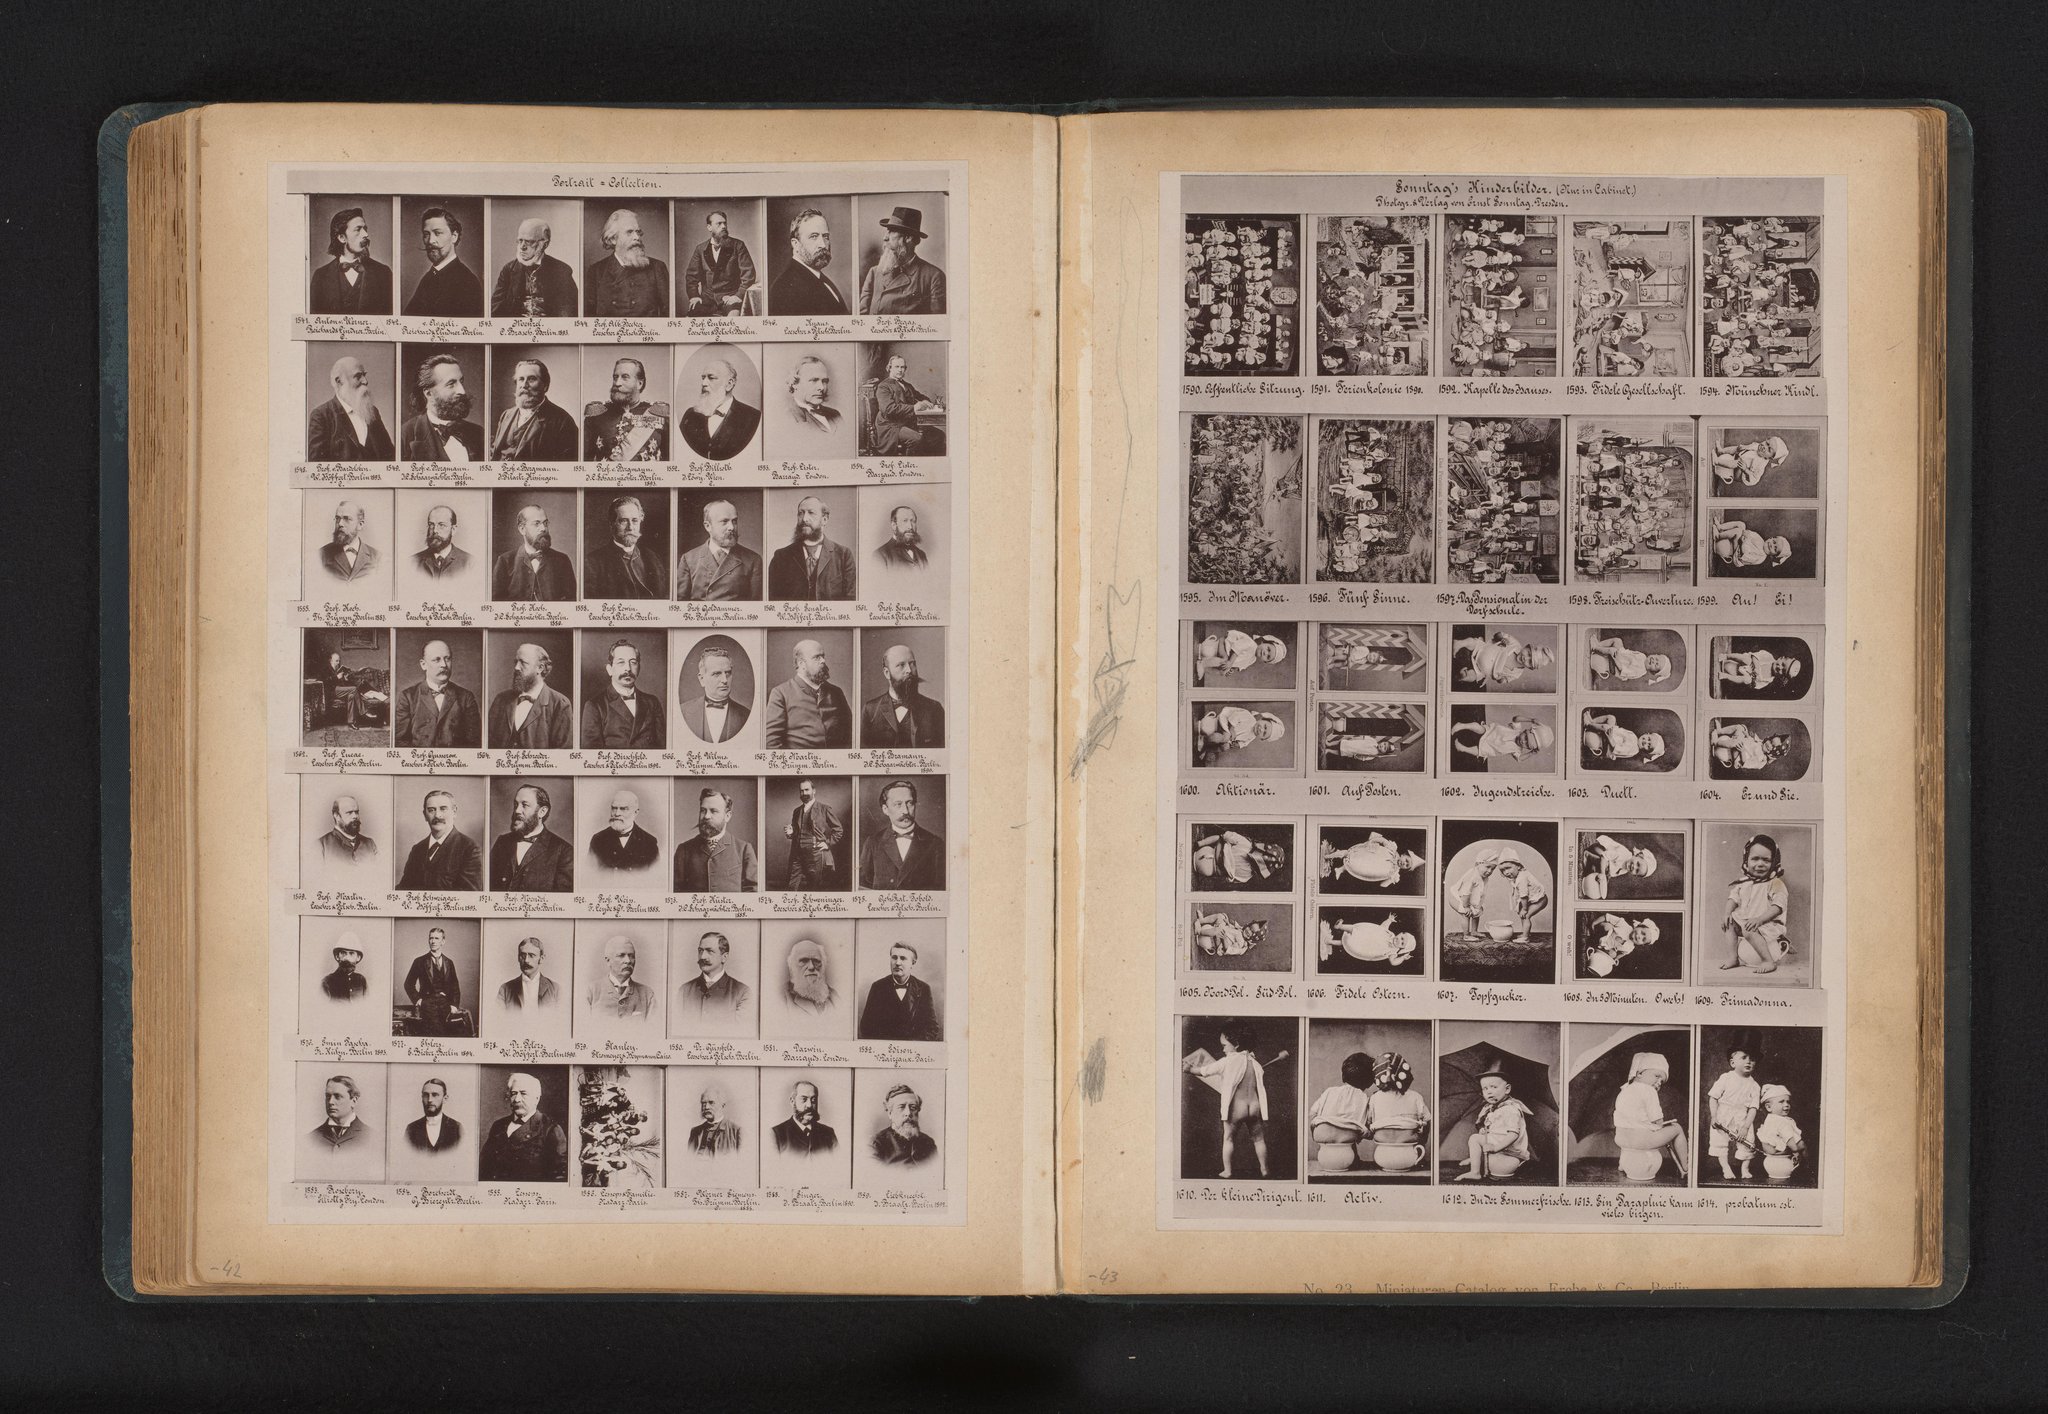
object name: page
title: Portretten van Duitse professoren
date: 1880-1885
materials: paper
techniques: photograph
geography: berlin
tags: professor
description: Prent op tweeënveertigste ongenummerde pagina.